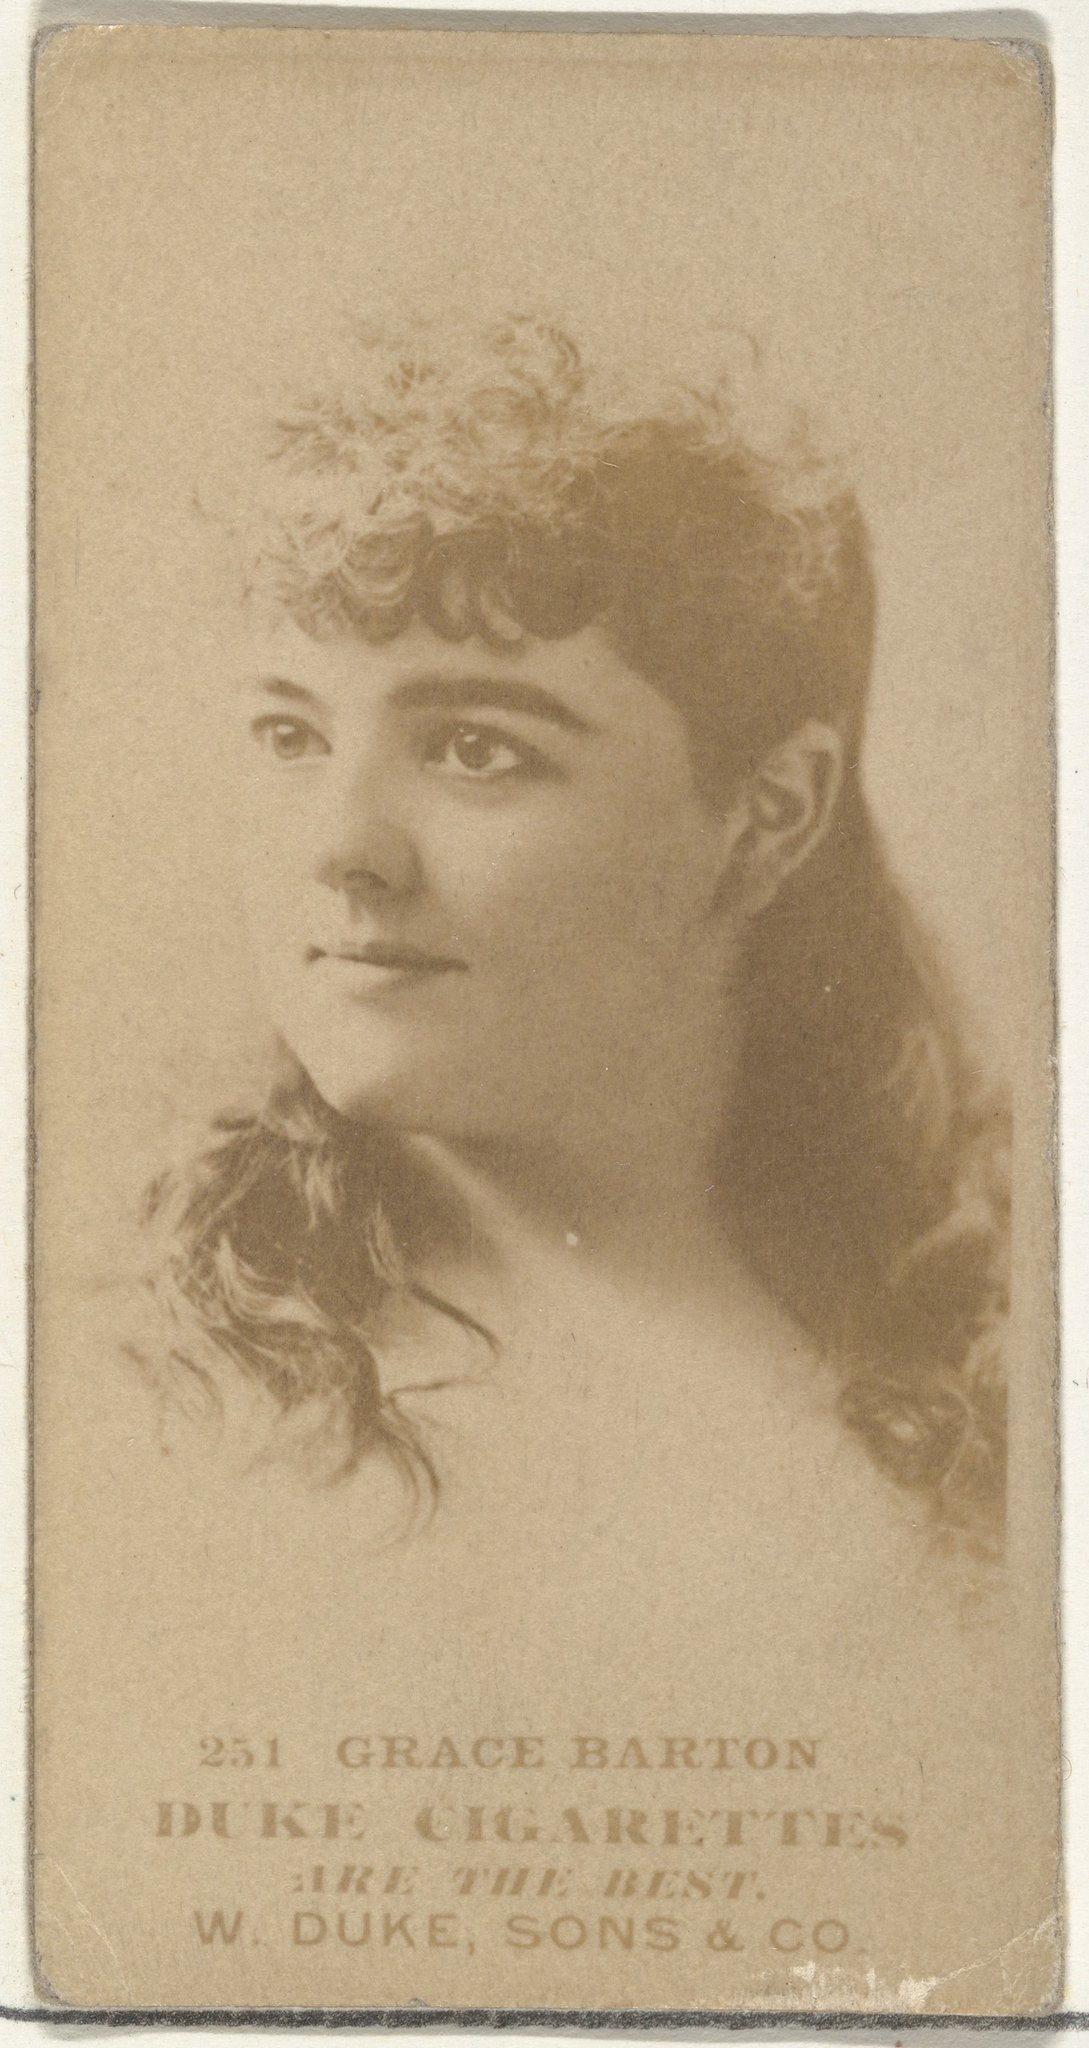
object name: photograph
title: Card Number 251, Grace Barton, from the Actors and Actresses series (N145-7) issued by Duke Sons & Co. to promote Duke Cigarettes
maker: w. duke, sons & co.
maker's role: publisher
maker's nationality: american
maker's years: 1870-1920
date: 1880-1889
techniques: albumen silver print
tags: portraits,women,actresses